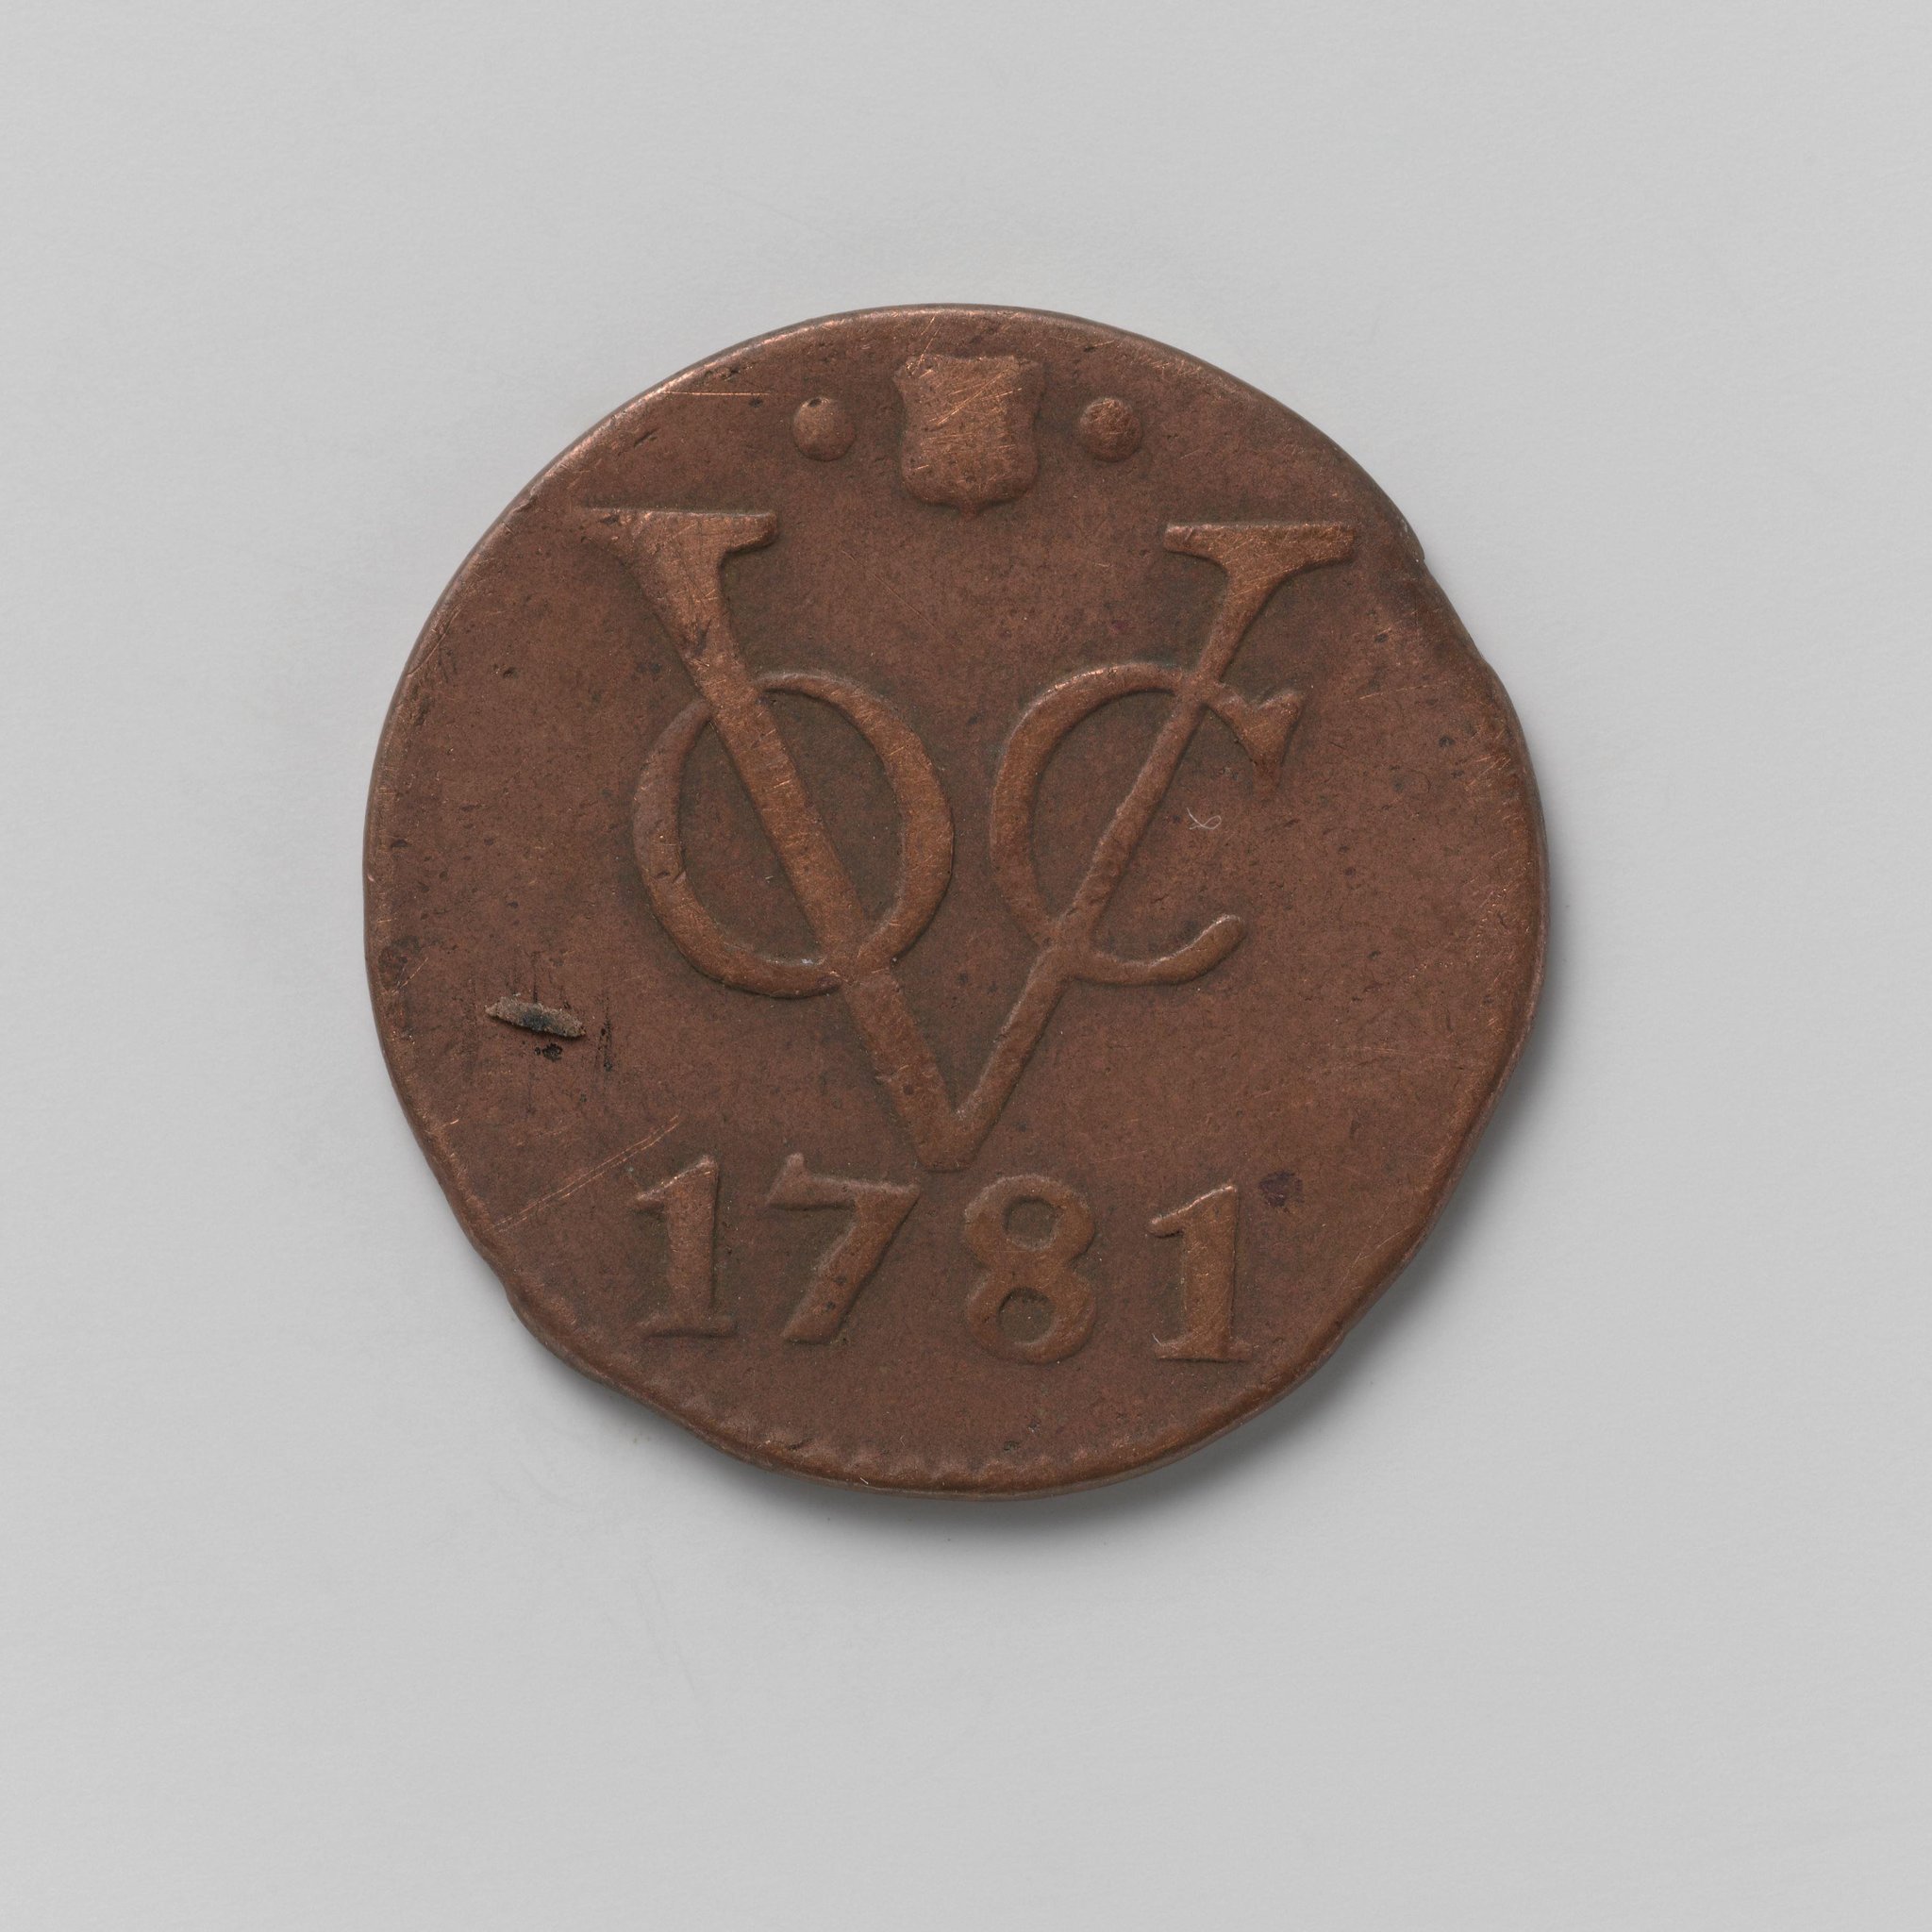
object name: coin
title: VOC, duit stad Utrecht,1781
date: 1781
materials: copper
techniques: striking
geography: utrecht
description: Koperen munt. Voorzijde: op balk, waaronder guirlande, geplaatst, door twee leeuwen gehouden gekroond wapenschild van de stad Utrecht. Keerzijde: monogram van de VOC, waarboven muntteken en waaronder jaartal. Gladde rand.